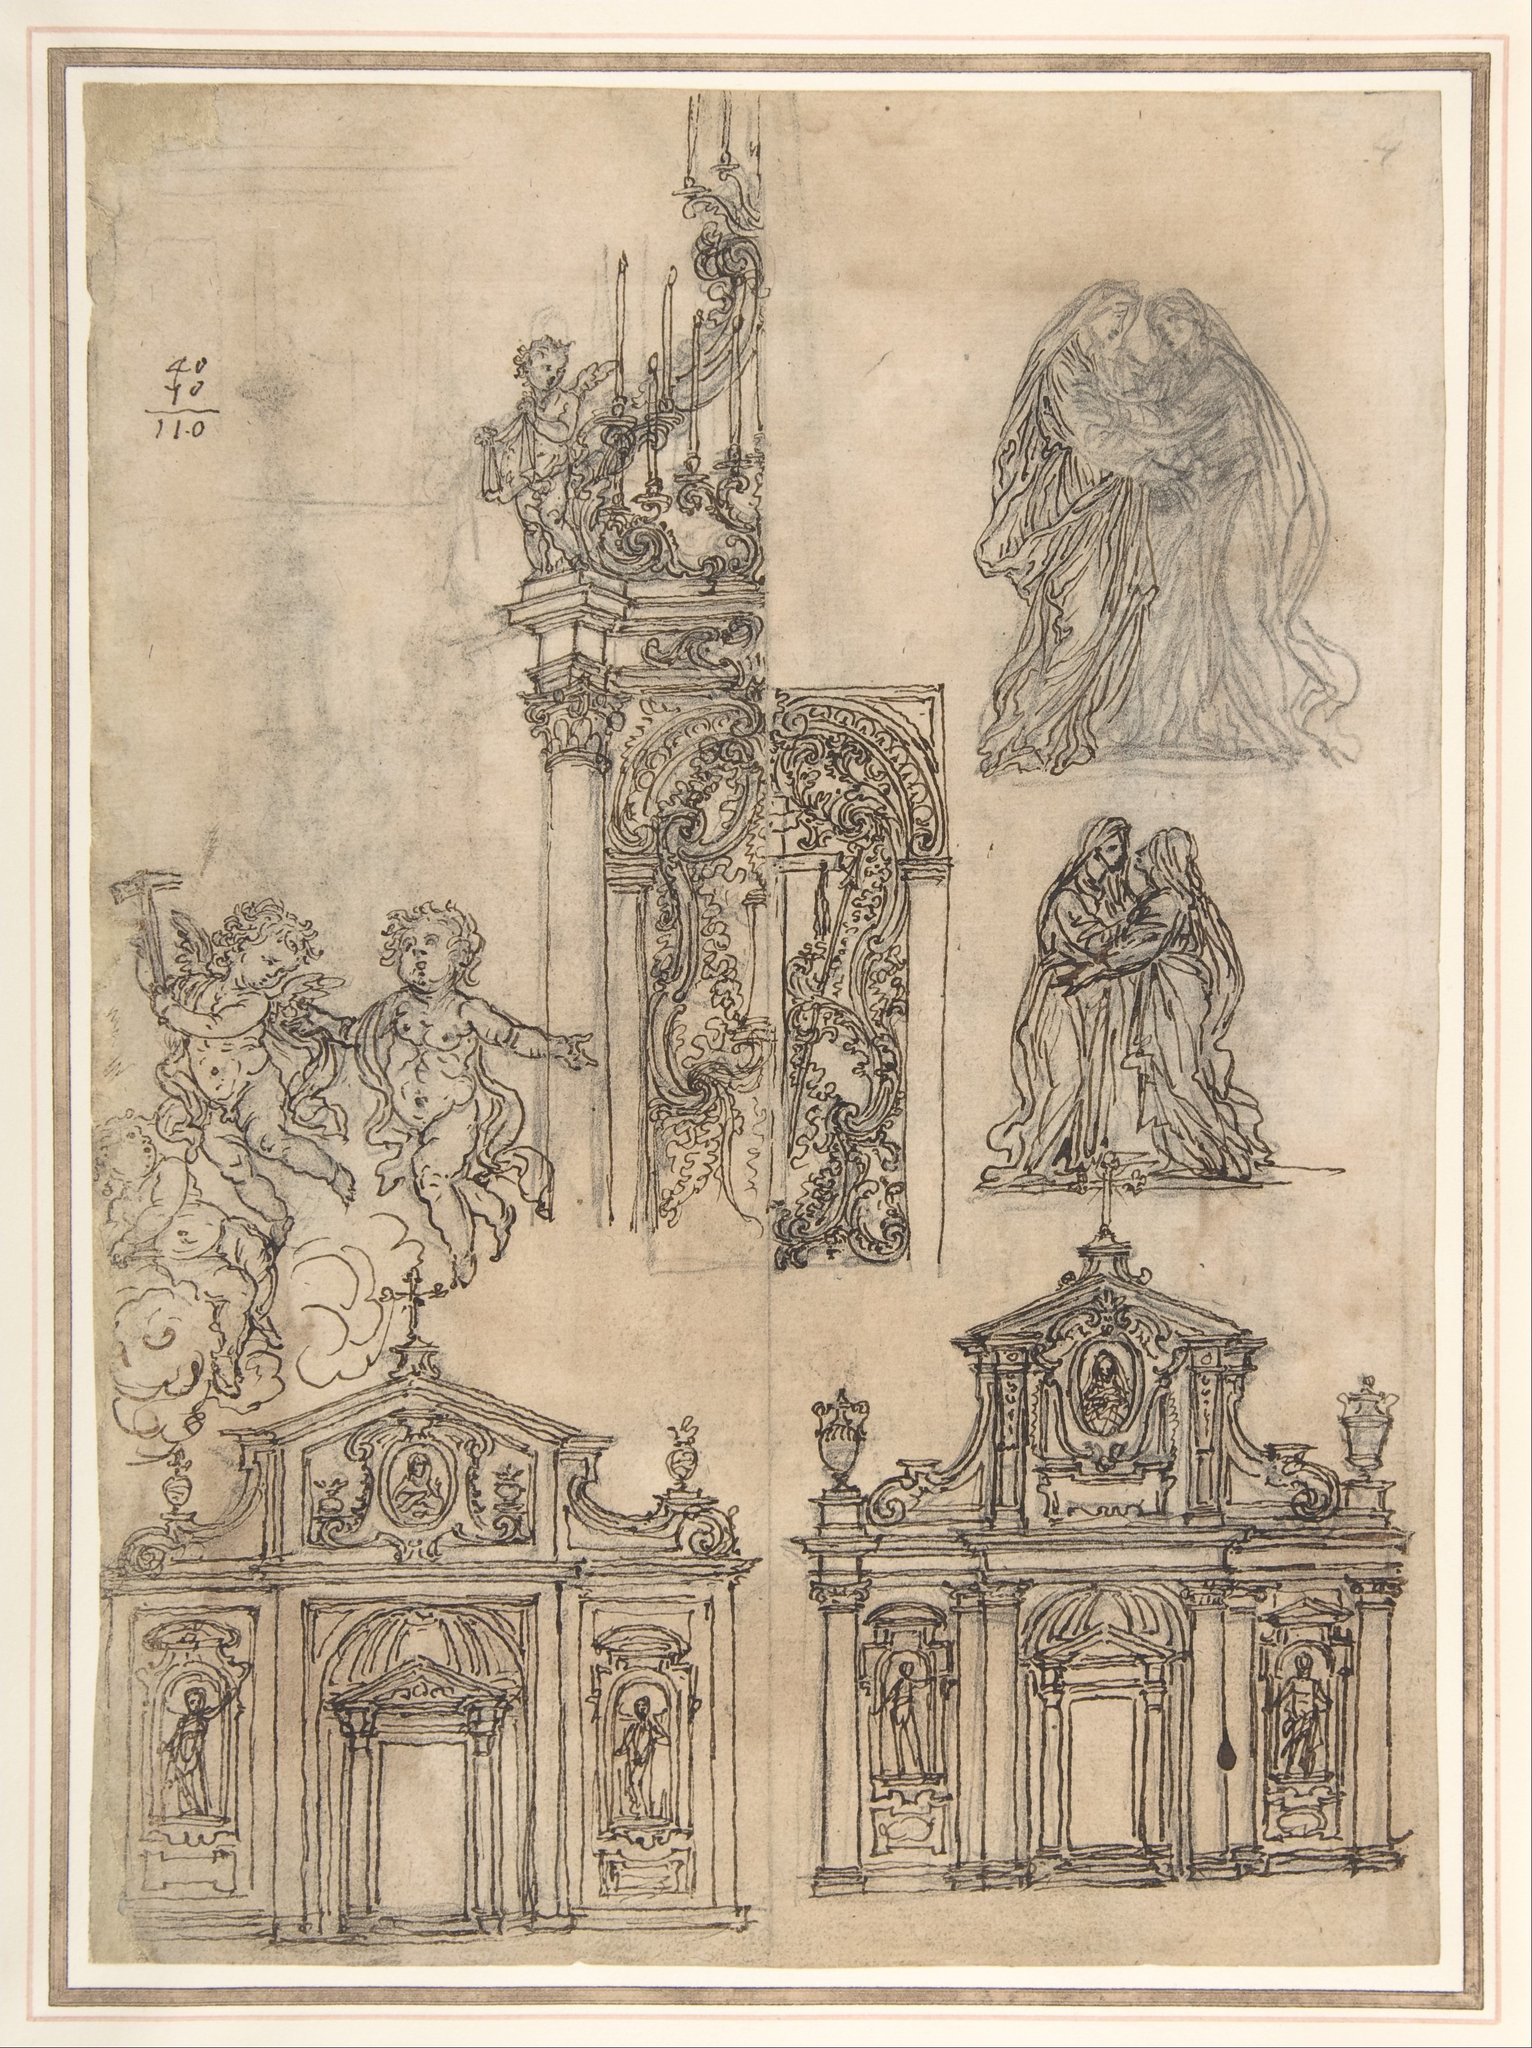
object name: drawing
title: A Sheet of Studies with Architectural Motifs and Two Sketches for a Visitation (recto); Sketch for a Funerary Monument (verso)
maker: giovanni battista foggini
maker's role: artist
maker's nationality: italian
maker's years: 1652-1725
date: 1672-1725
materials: chalk, ink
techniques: pen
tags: architecture